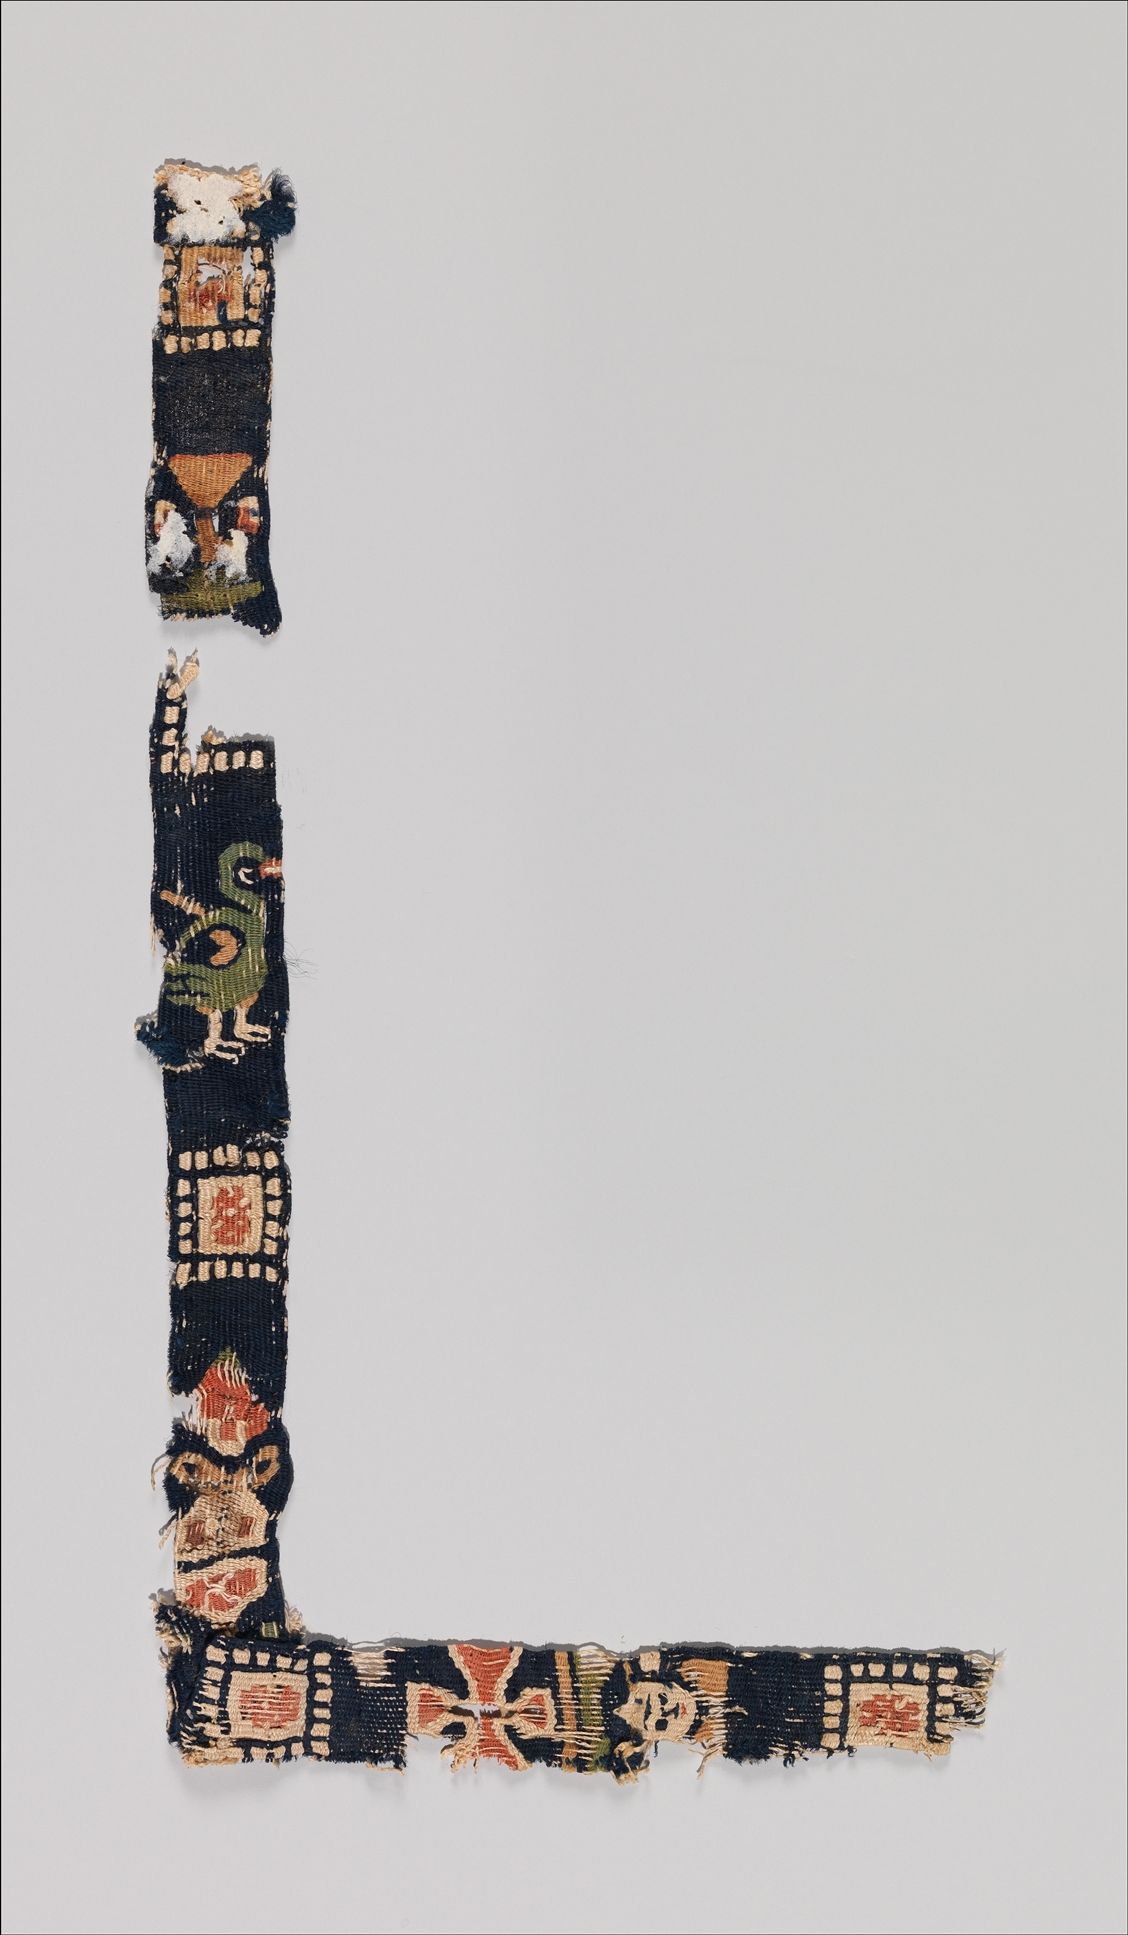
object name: textile fragment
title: Fragment of a Band with Birds, Cross, and Head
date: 401-700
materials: linen, wool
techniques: weave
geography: egypt